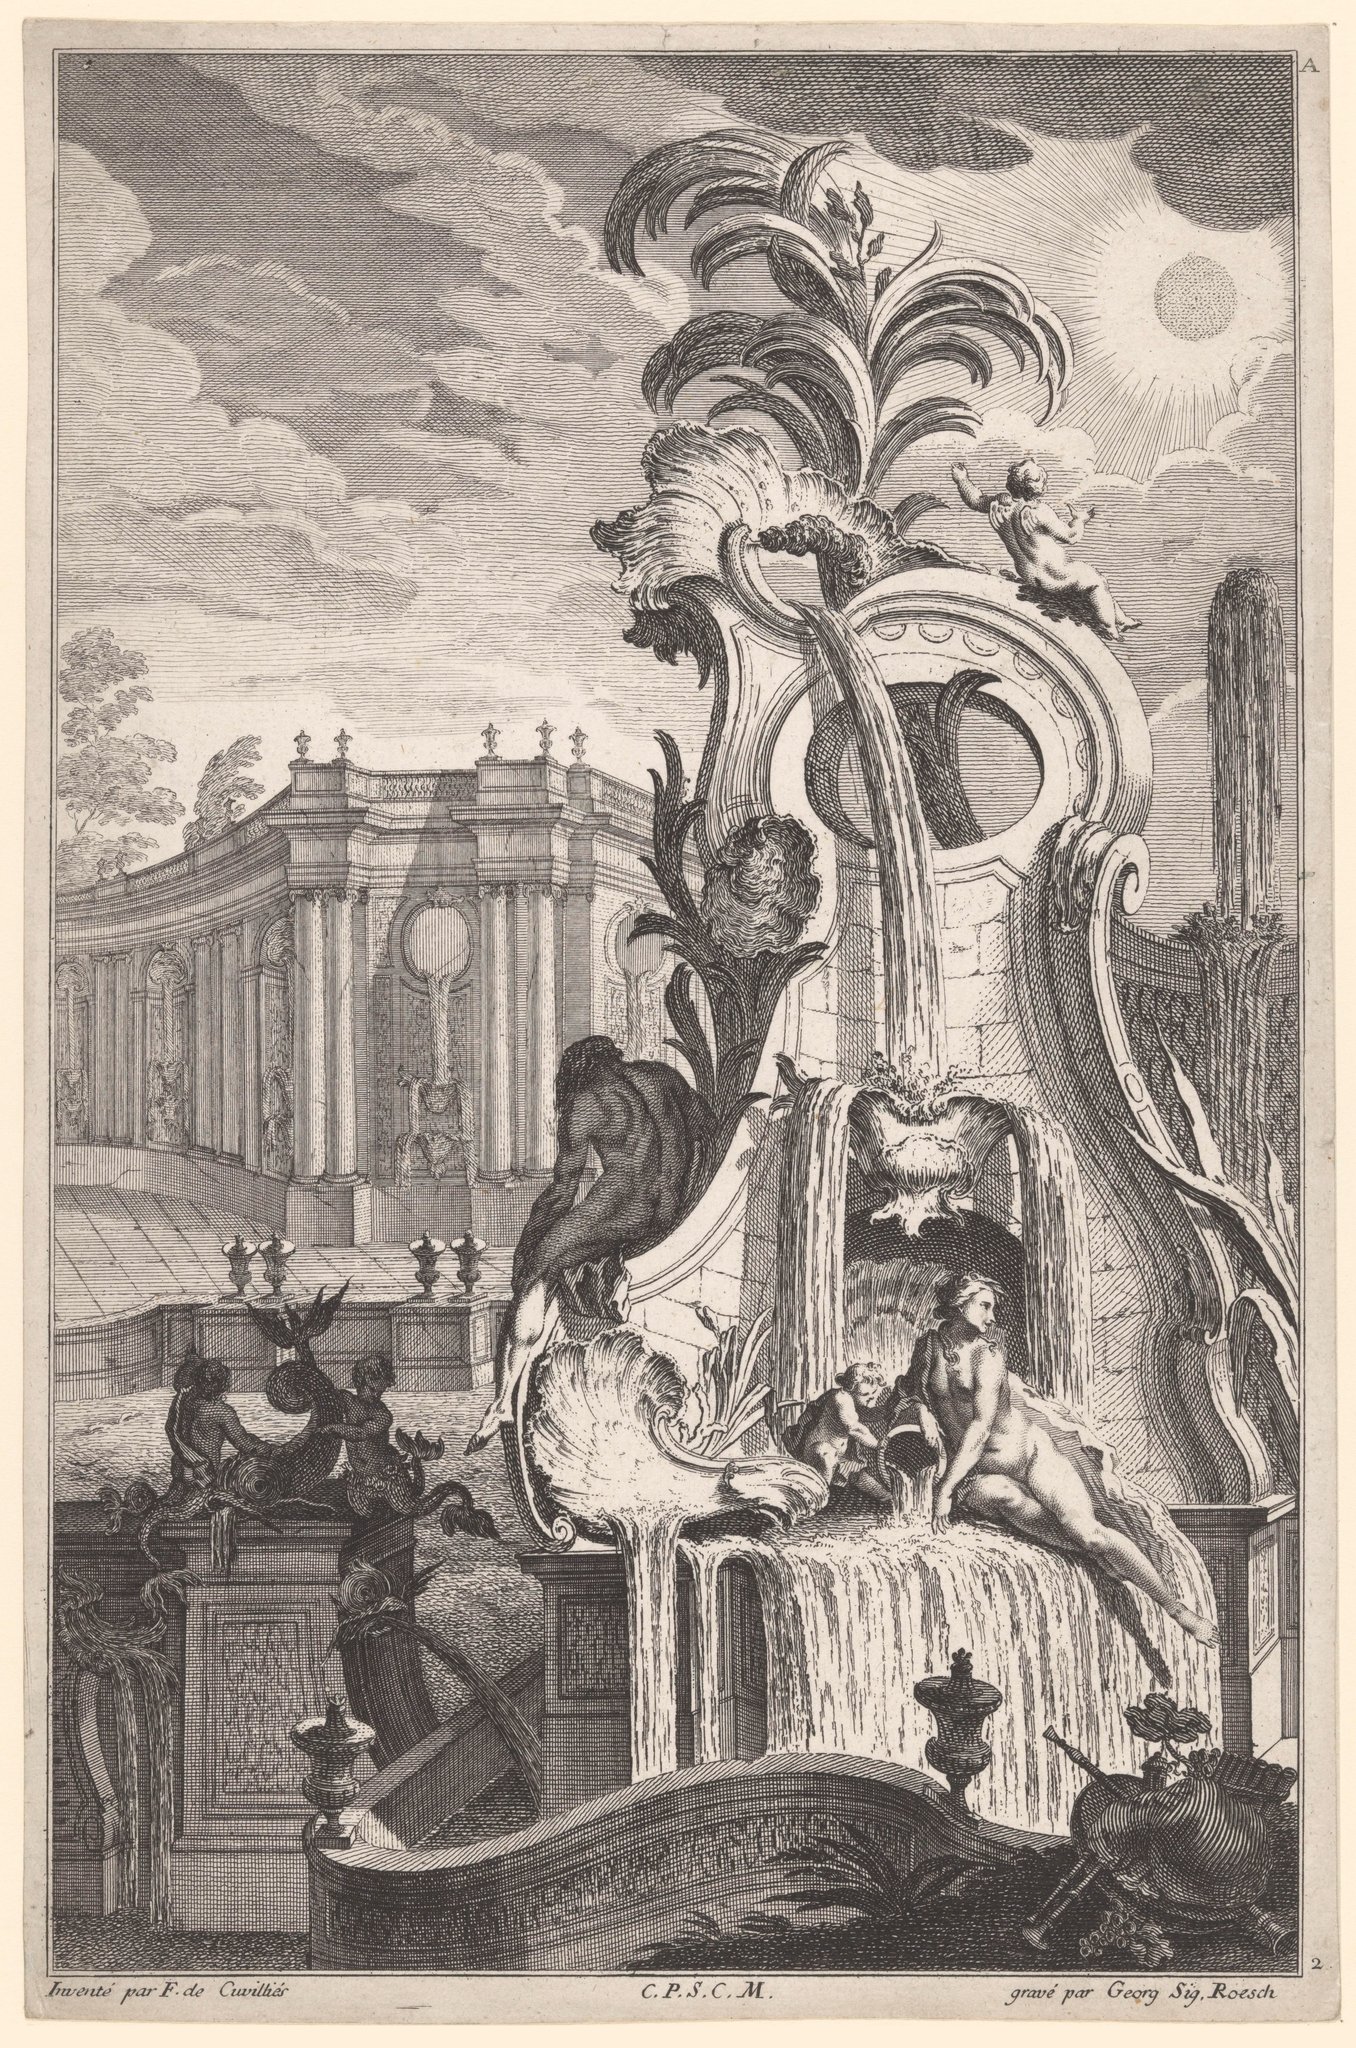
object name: ornament print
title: 1r Livre A Morceaux de Caprice propres à divers usages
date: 1745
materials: paper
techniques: engraving, etching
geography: germany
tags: musical instruments; group of musical instruments, sitting figure, scallop, shell ~ ornament, ornamental fountain, cupids: 'amores', 'amoretti', 'putti'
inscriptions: collector's mark: Lugt 2228, collector's mark: Lugt 2760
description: Een fontein met schelpmotieven, een zittende man op de rug gezien, een zittende vrouw en twee putti. Links zitten twee kinderen met vissenstaarten naast een dolfijn. Rechts op de voorgrond liggen een panfluit, een doedelzak en druivenranken. In de achtergrond architectuur met zuilen en kleine fonteinen.